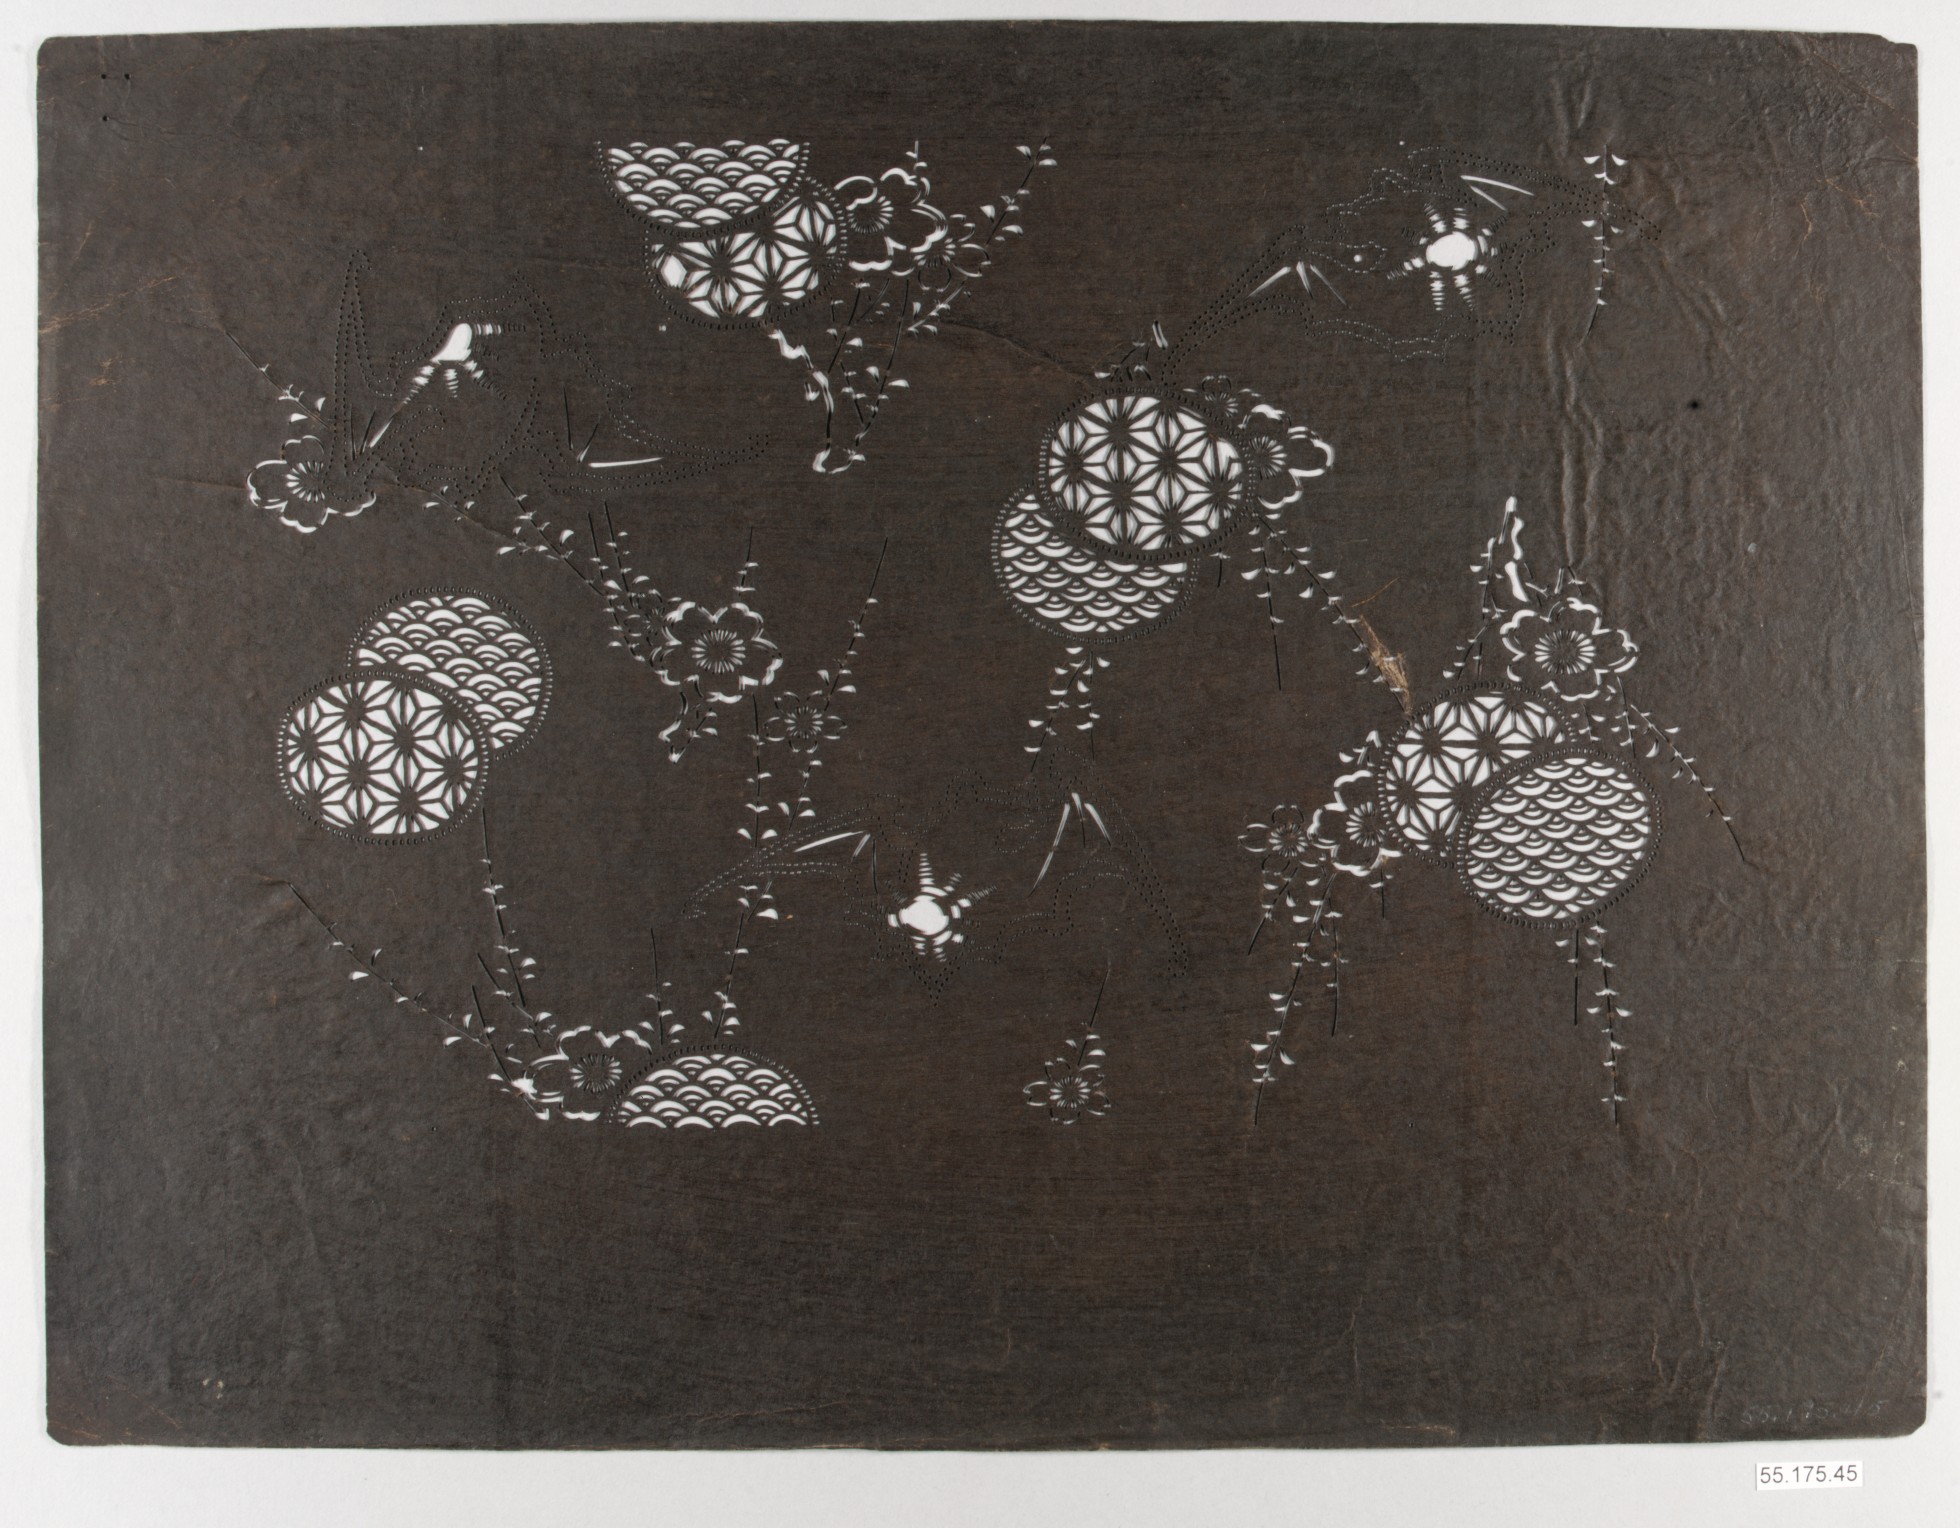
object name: stencil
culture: japanese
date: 1801-1900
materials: paper